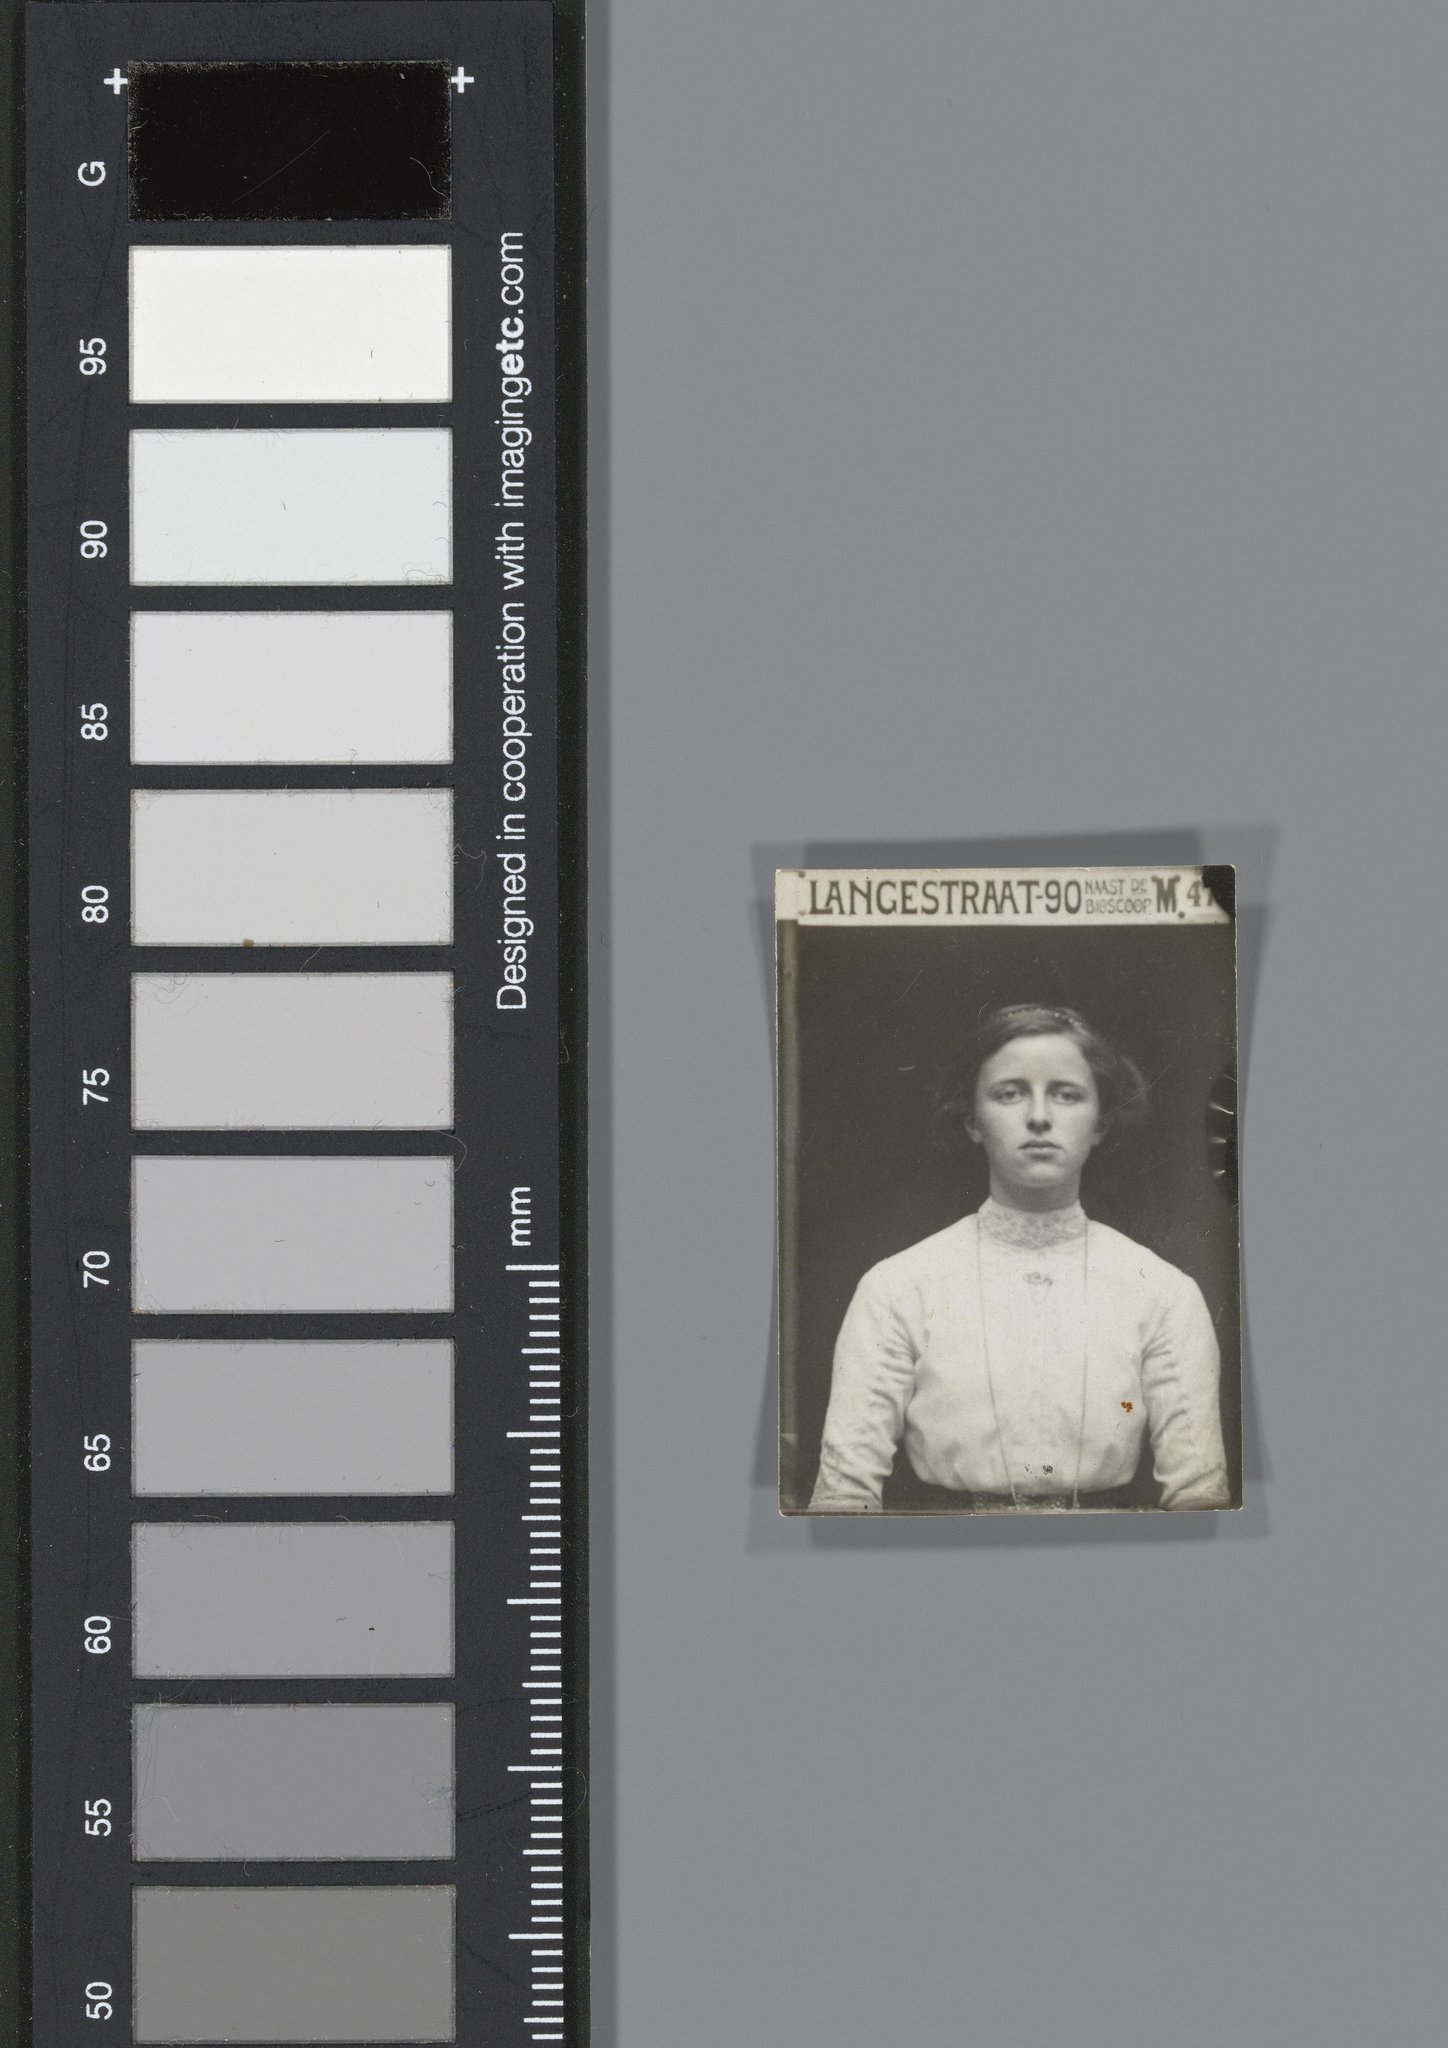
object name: snapshot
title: Rapid photographs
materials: photographic support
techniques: gelatin silver print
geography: alkmaar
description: Between 1912 and 1930, anyone could have their portrait taken at the many so-called rapid photography studios in the shopping streets of mainly (medium) large-size European cities. As if on an assembly line, the youngest clerk shot the photographs with a special camera and in artificial light and developed them. Later in the day, the customer collected a sheet with 12 portrait photos for 25 cents. This form of photographic mass production gave rise to a fascinating tableau of boys, girls, men and women not previously seen in photographs; candid and informal. There were at least 150 quick-photo studios, from Alkmaar to Zutphen. Many called themselves ‘American,’ mistakenly as it turns out because hardly any examples from that country have been found.